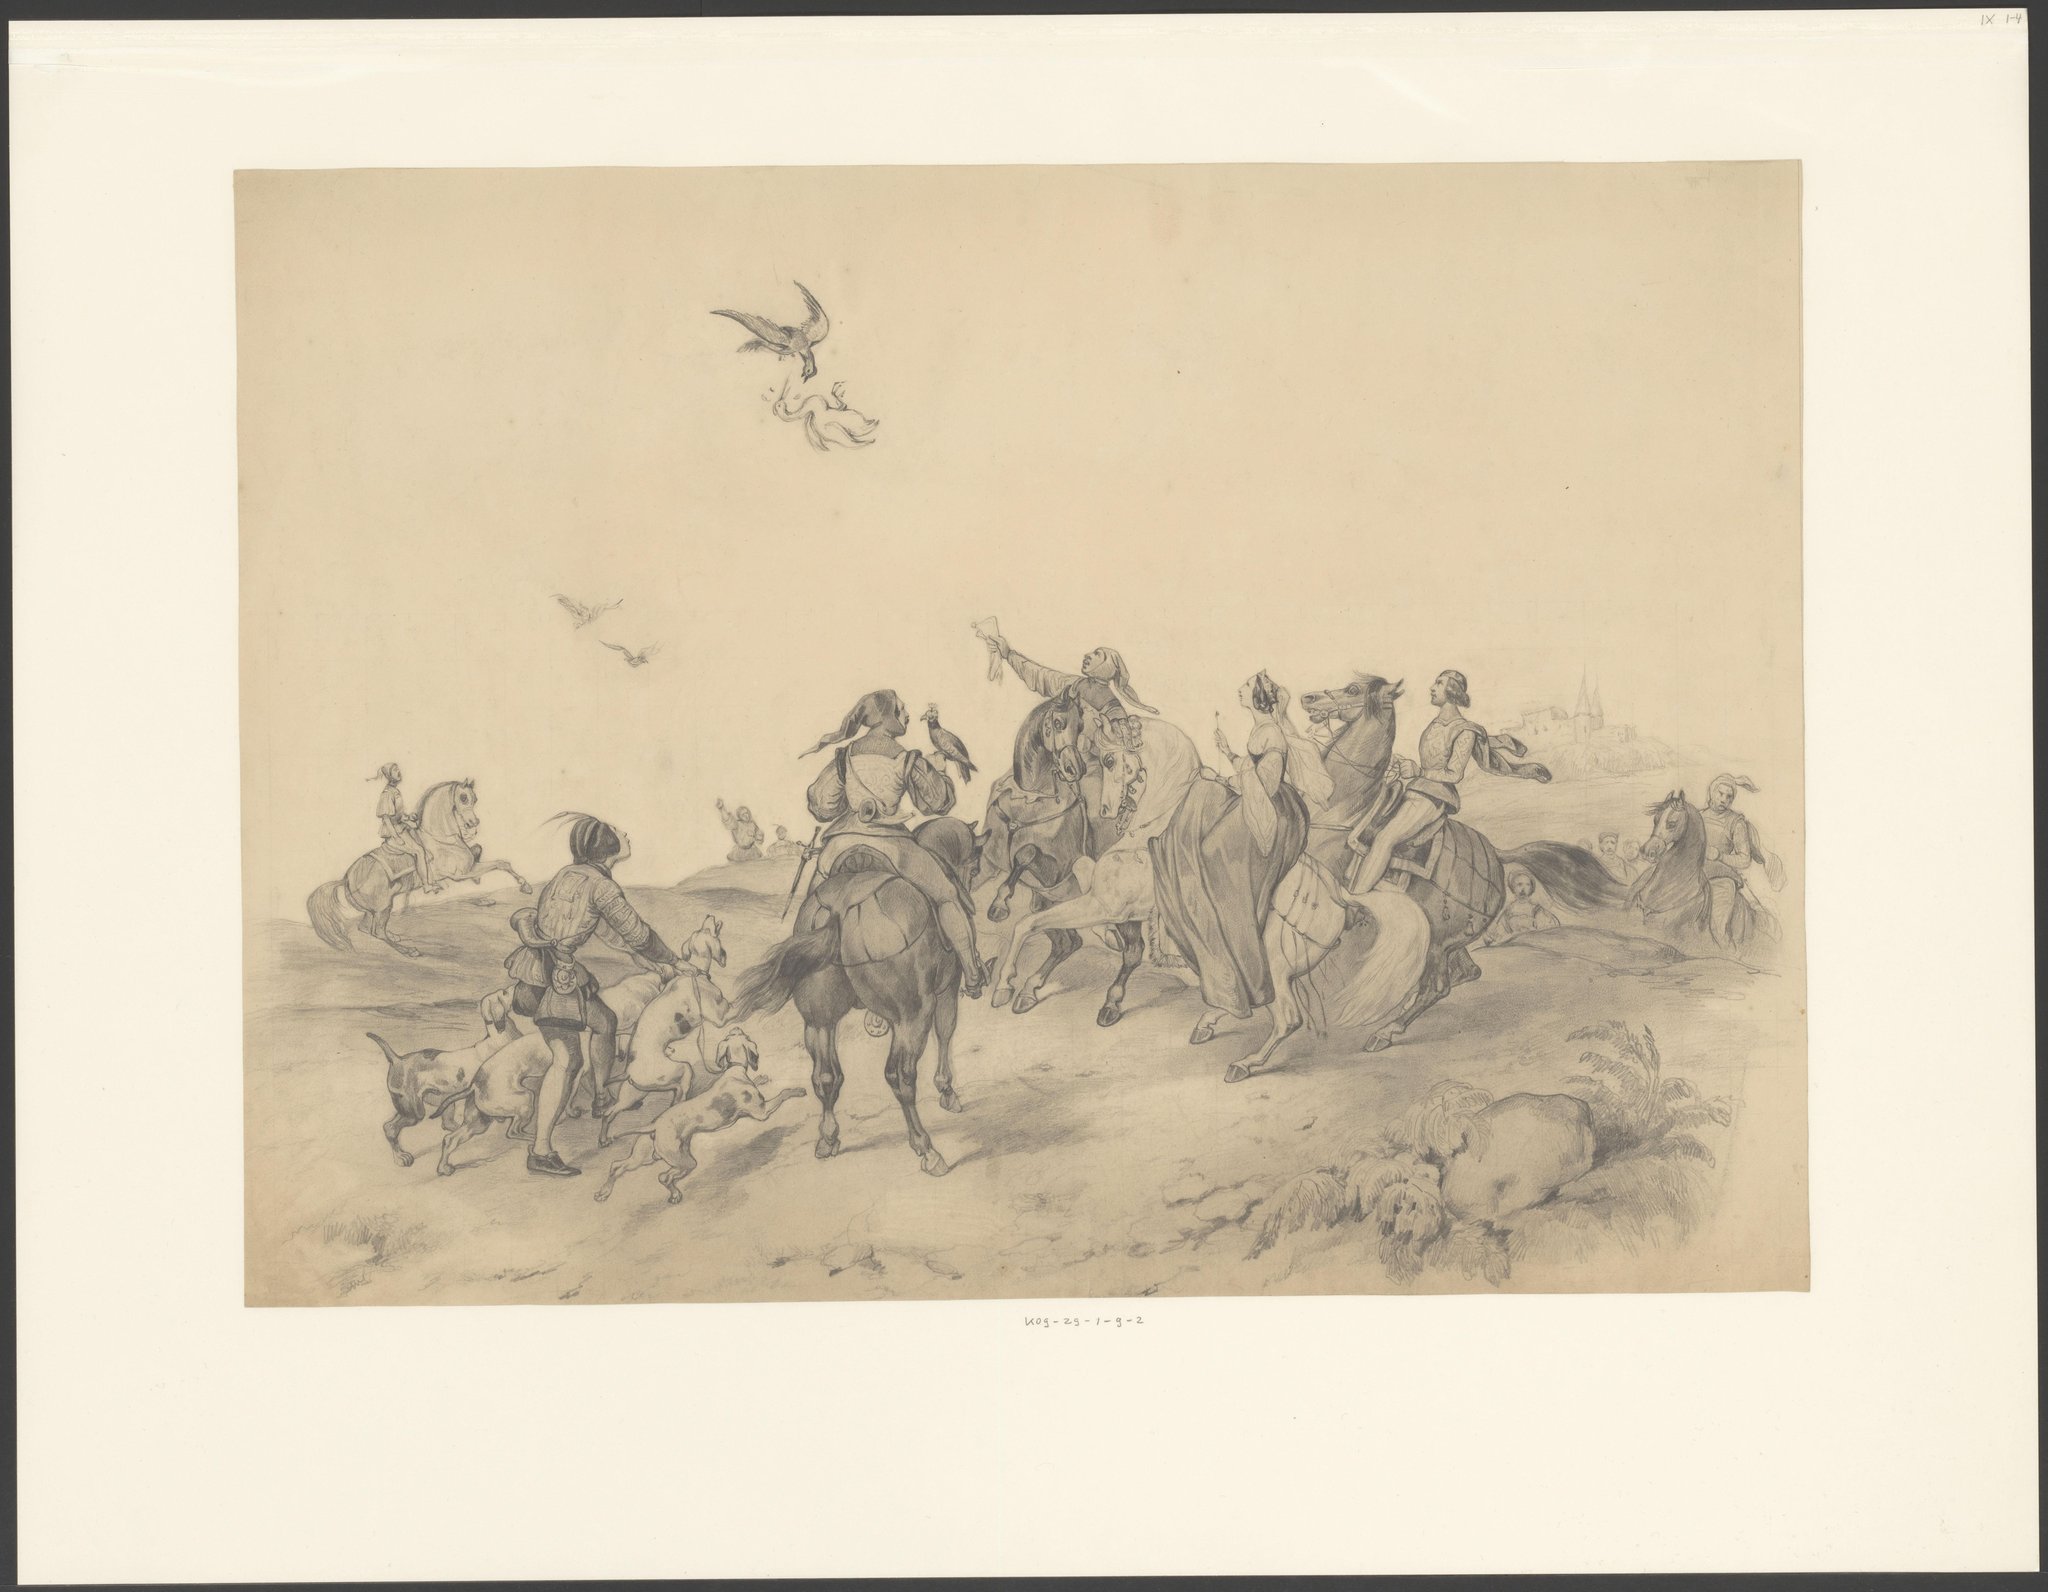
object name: drawing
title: Valkenjacht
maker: Anonymous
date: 1800-1899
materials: chalk, paper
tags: predatory birds: falcon, game, hunted animals, bird hunting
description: Mannen en een vrouw te paard tijdens de valkenjacht. Onderwerpsrubrieken binnen de Atlas Zeden en Gewoonten: Handel, nijverheid en verkeer, jacht.